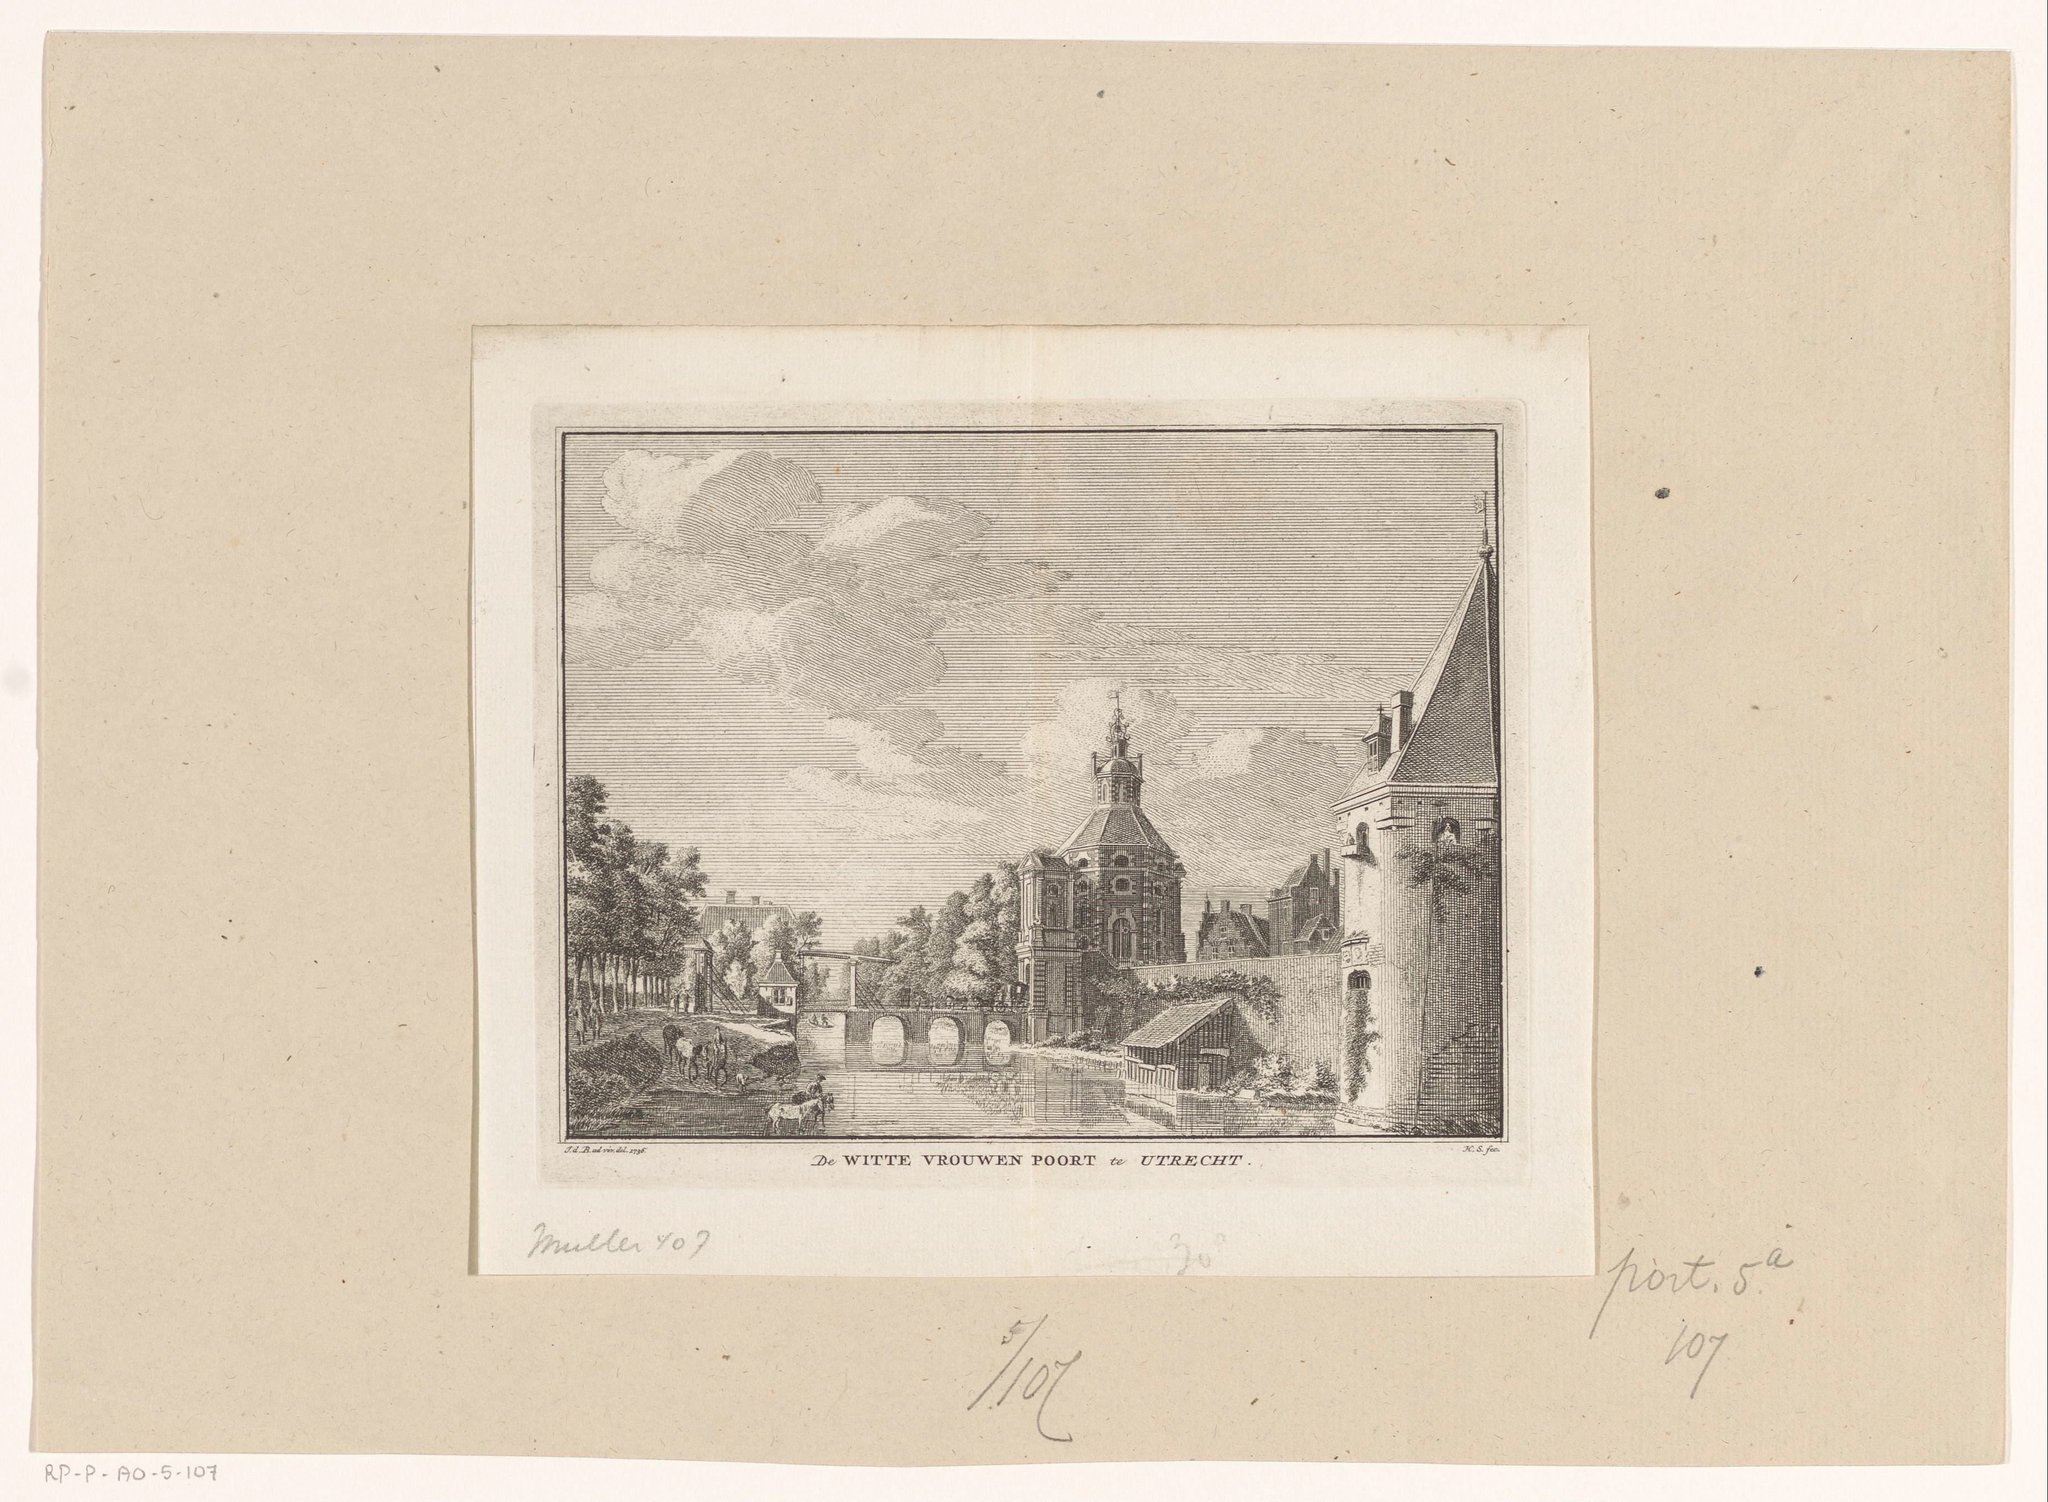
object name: print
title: Gezicht op de Wittevrouwenpoort te Utrecht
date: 1773-1792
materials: paper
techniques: engraving, etching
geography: haarlem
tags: city-walls, bridge, city-gate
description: Prent ook gebruikt in: Het verheerlykt Nederland of kabinet van hedendaagsche gezigten van steden, dorpen (…) Behelzende honderd gezigten van der Provincie van Utrecht. Amsterdam: weduwe Isaak Tirion, 1773-1774, dl. 7, 8 of 9, niet genummerd, te vinden na ill. 144 en voor ill. 201. Of in: Nederlandsche tafereelen; of eene keurige verzameling van negen honderd fraaije gezigten van steden, dorpen, sloten, oudheden (….). 9 delen. Amsterdam: Jan de Groot, 1792, dl. 7, 8 of 9, niet genummerd, te vinden na ill. 144 en voor ill. 201. Uit welke druk het huidige exemplaar precies komt is niet na te gaan.